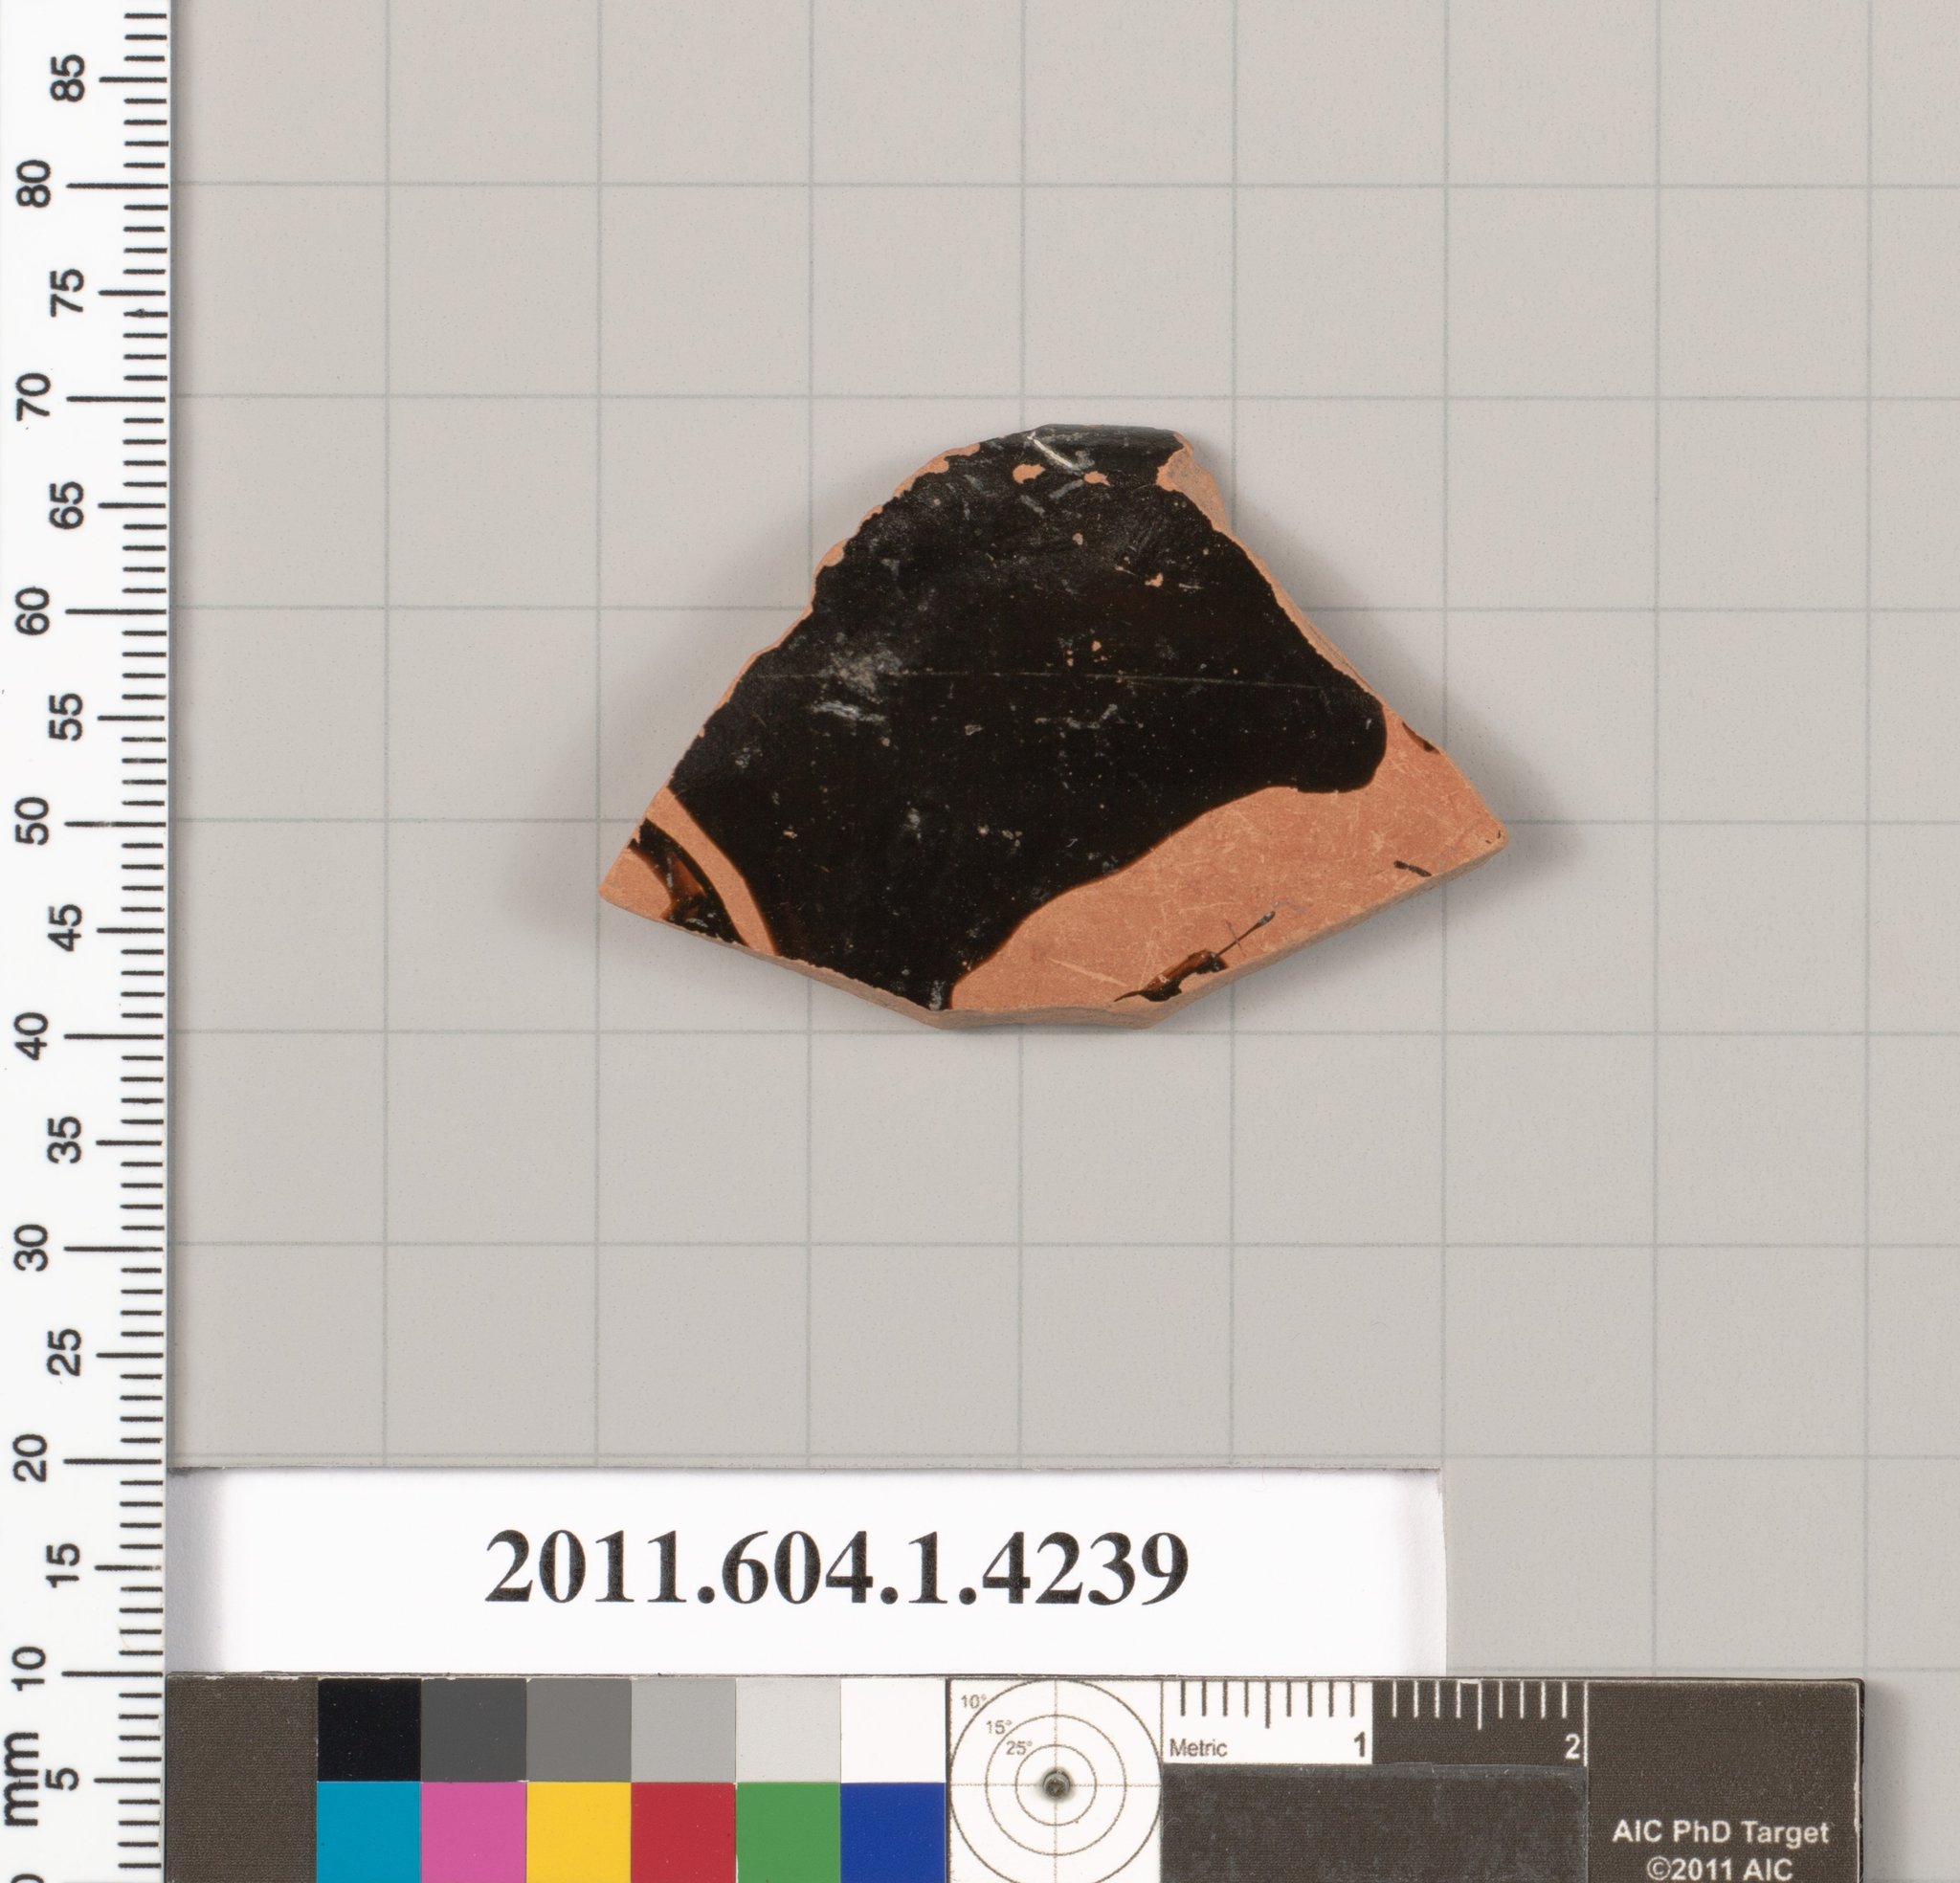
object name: kylix fragment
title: Terracotta fragment of a kylix (drinking cup)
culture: greek, attic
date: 467-435 BCE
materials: terracotta